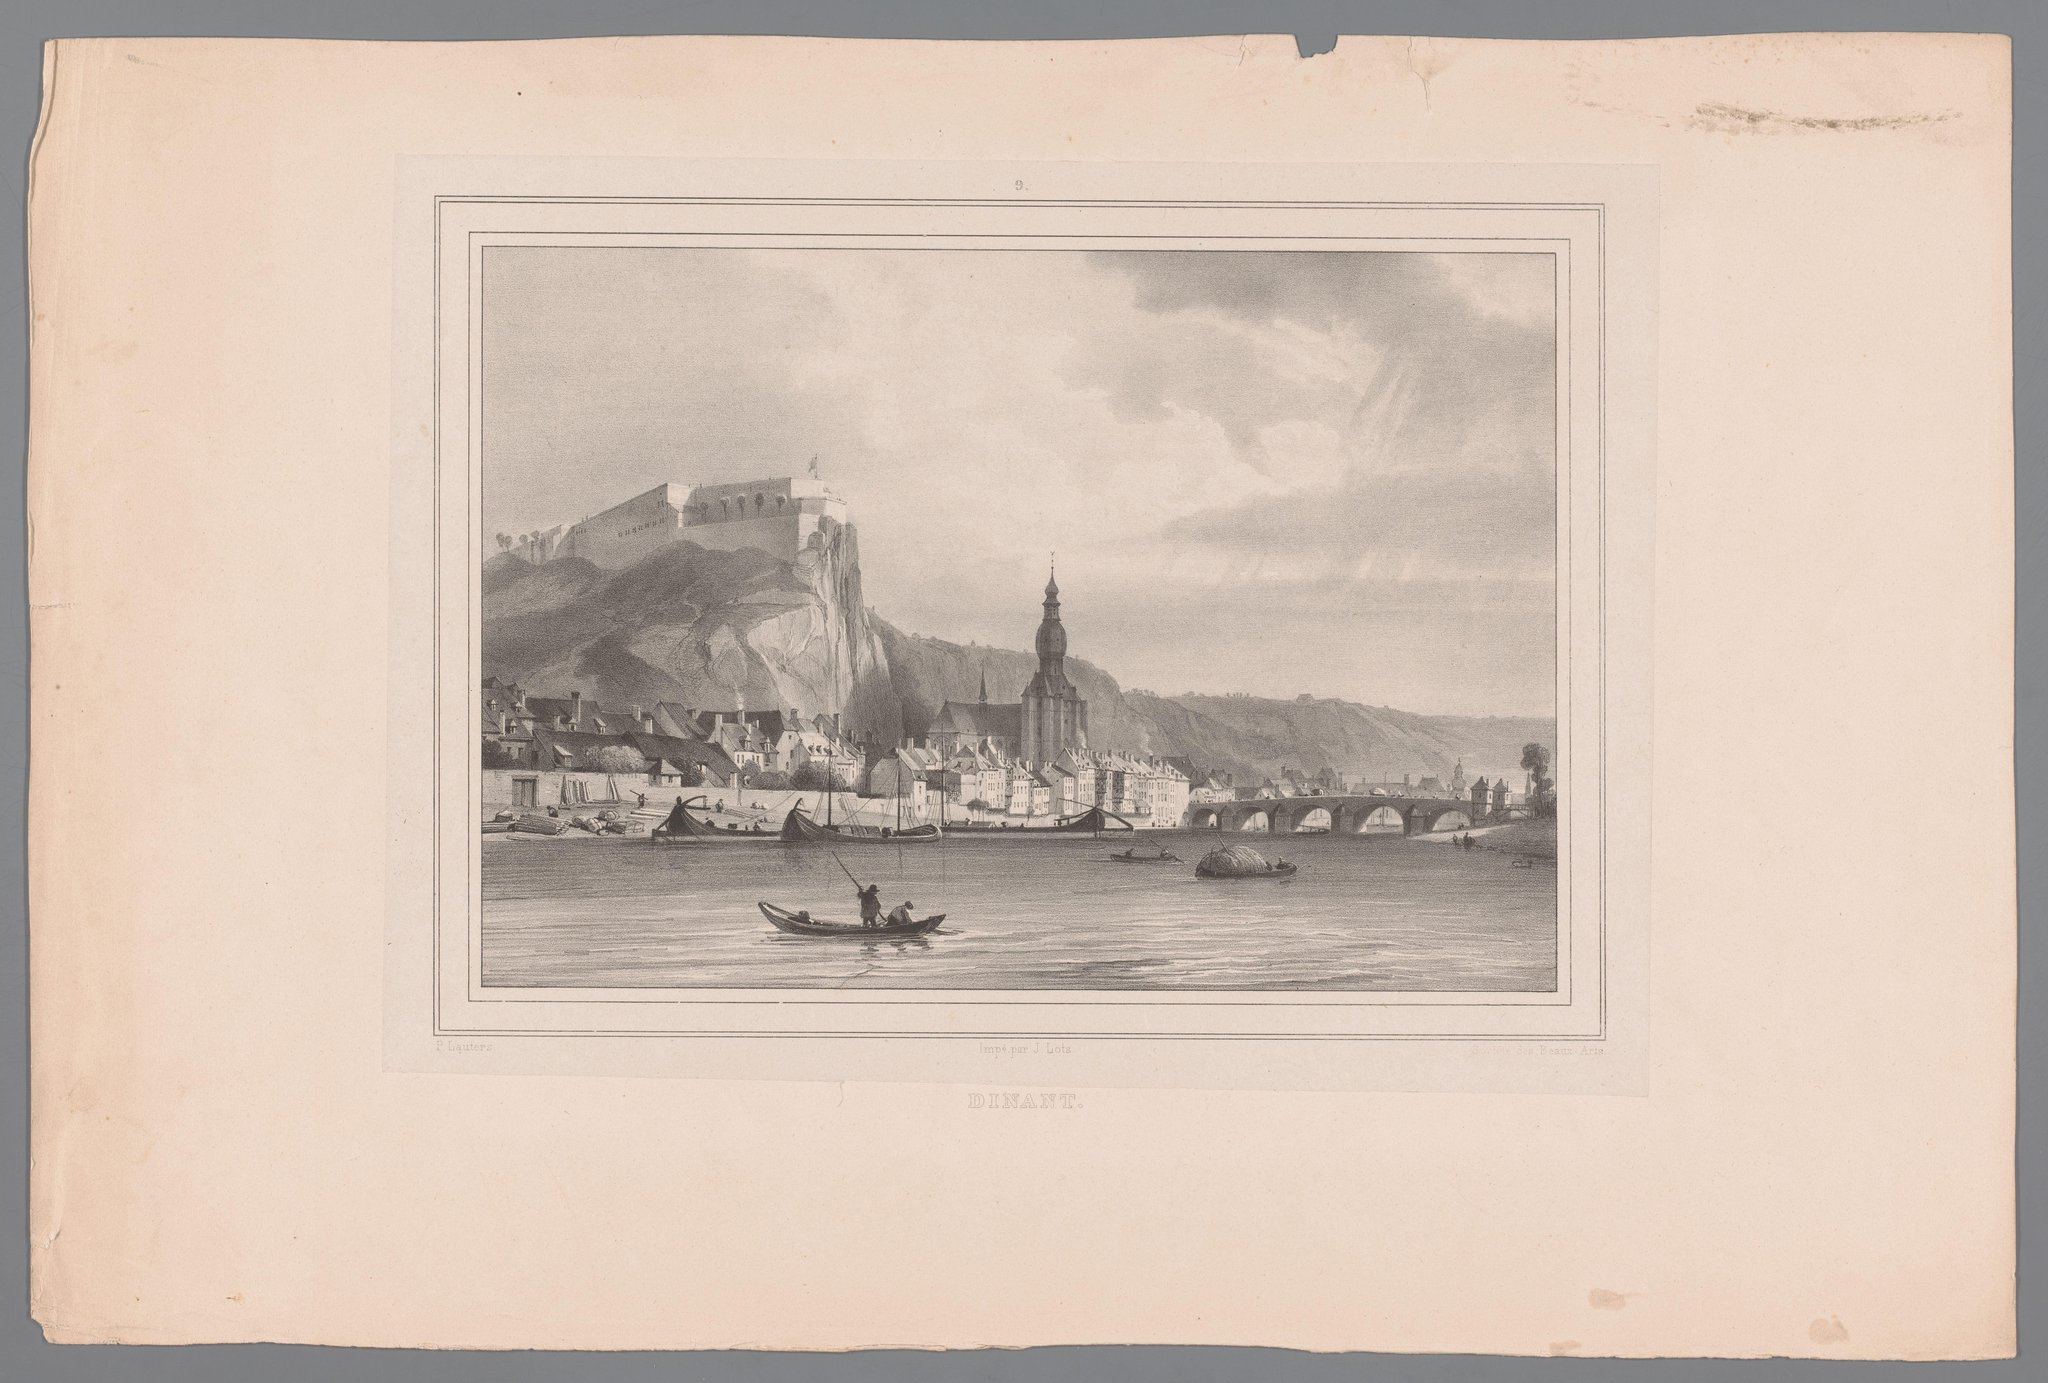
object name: print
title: Dinant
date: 1839-1841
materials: paper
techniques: lithograph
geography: brussels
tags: river, prospect of city, town panorama, silhouette of city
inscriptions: collector's mark: Lugt 2228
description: Prent verschenen in: Van Hasselt, André. Voyage aux bords de la Meuse. Brussel: Société des Beaux-Arts, 1839-1841. Deze publicatie bevat 36 litho's.